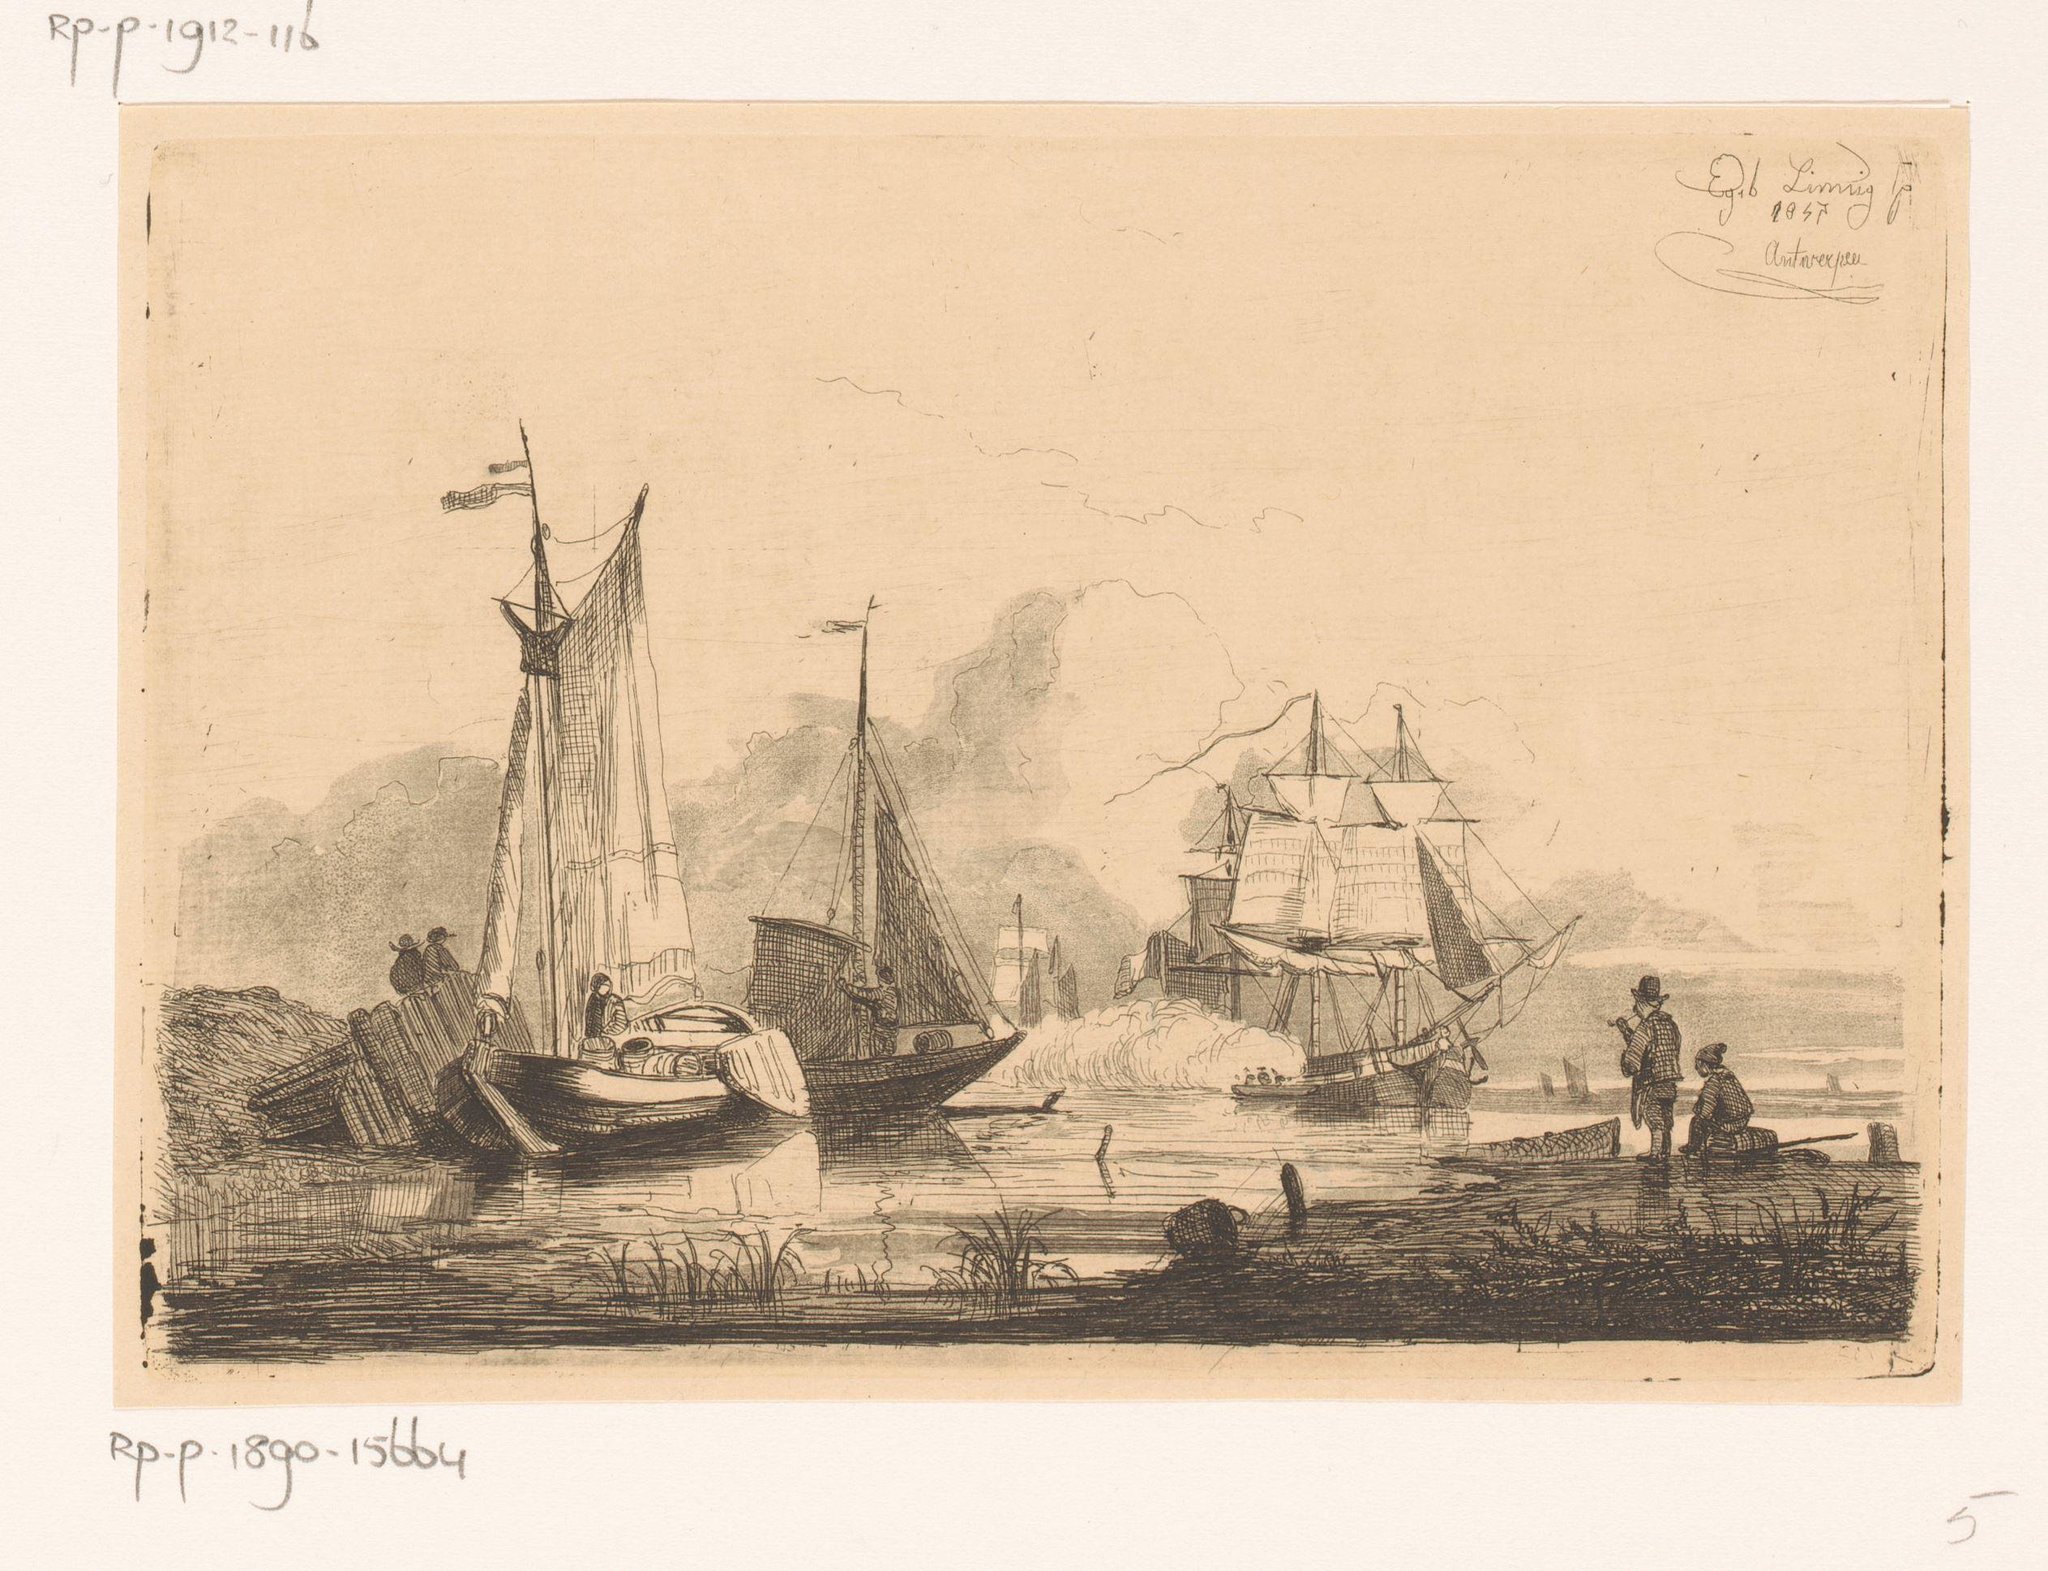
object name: print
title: Saluutschoten bij het uitzeilen van de driemaster Macassar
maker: egidius linnig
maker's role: draughtsman, print maker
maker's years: 1821-1860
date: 1847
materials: paper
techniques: aquatint, etching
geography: antwerp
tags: sailing-ship, sailing-boat, firearms: cannon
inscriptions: collector's mark: Lugt 2228